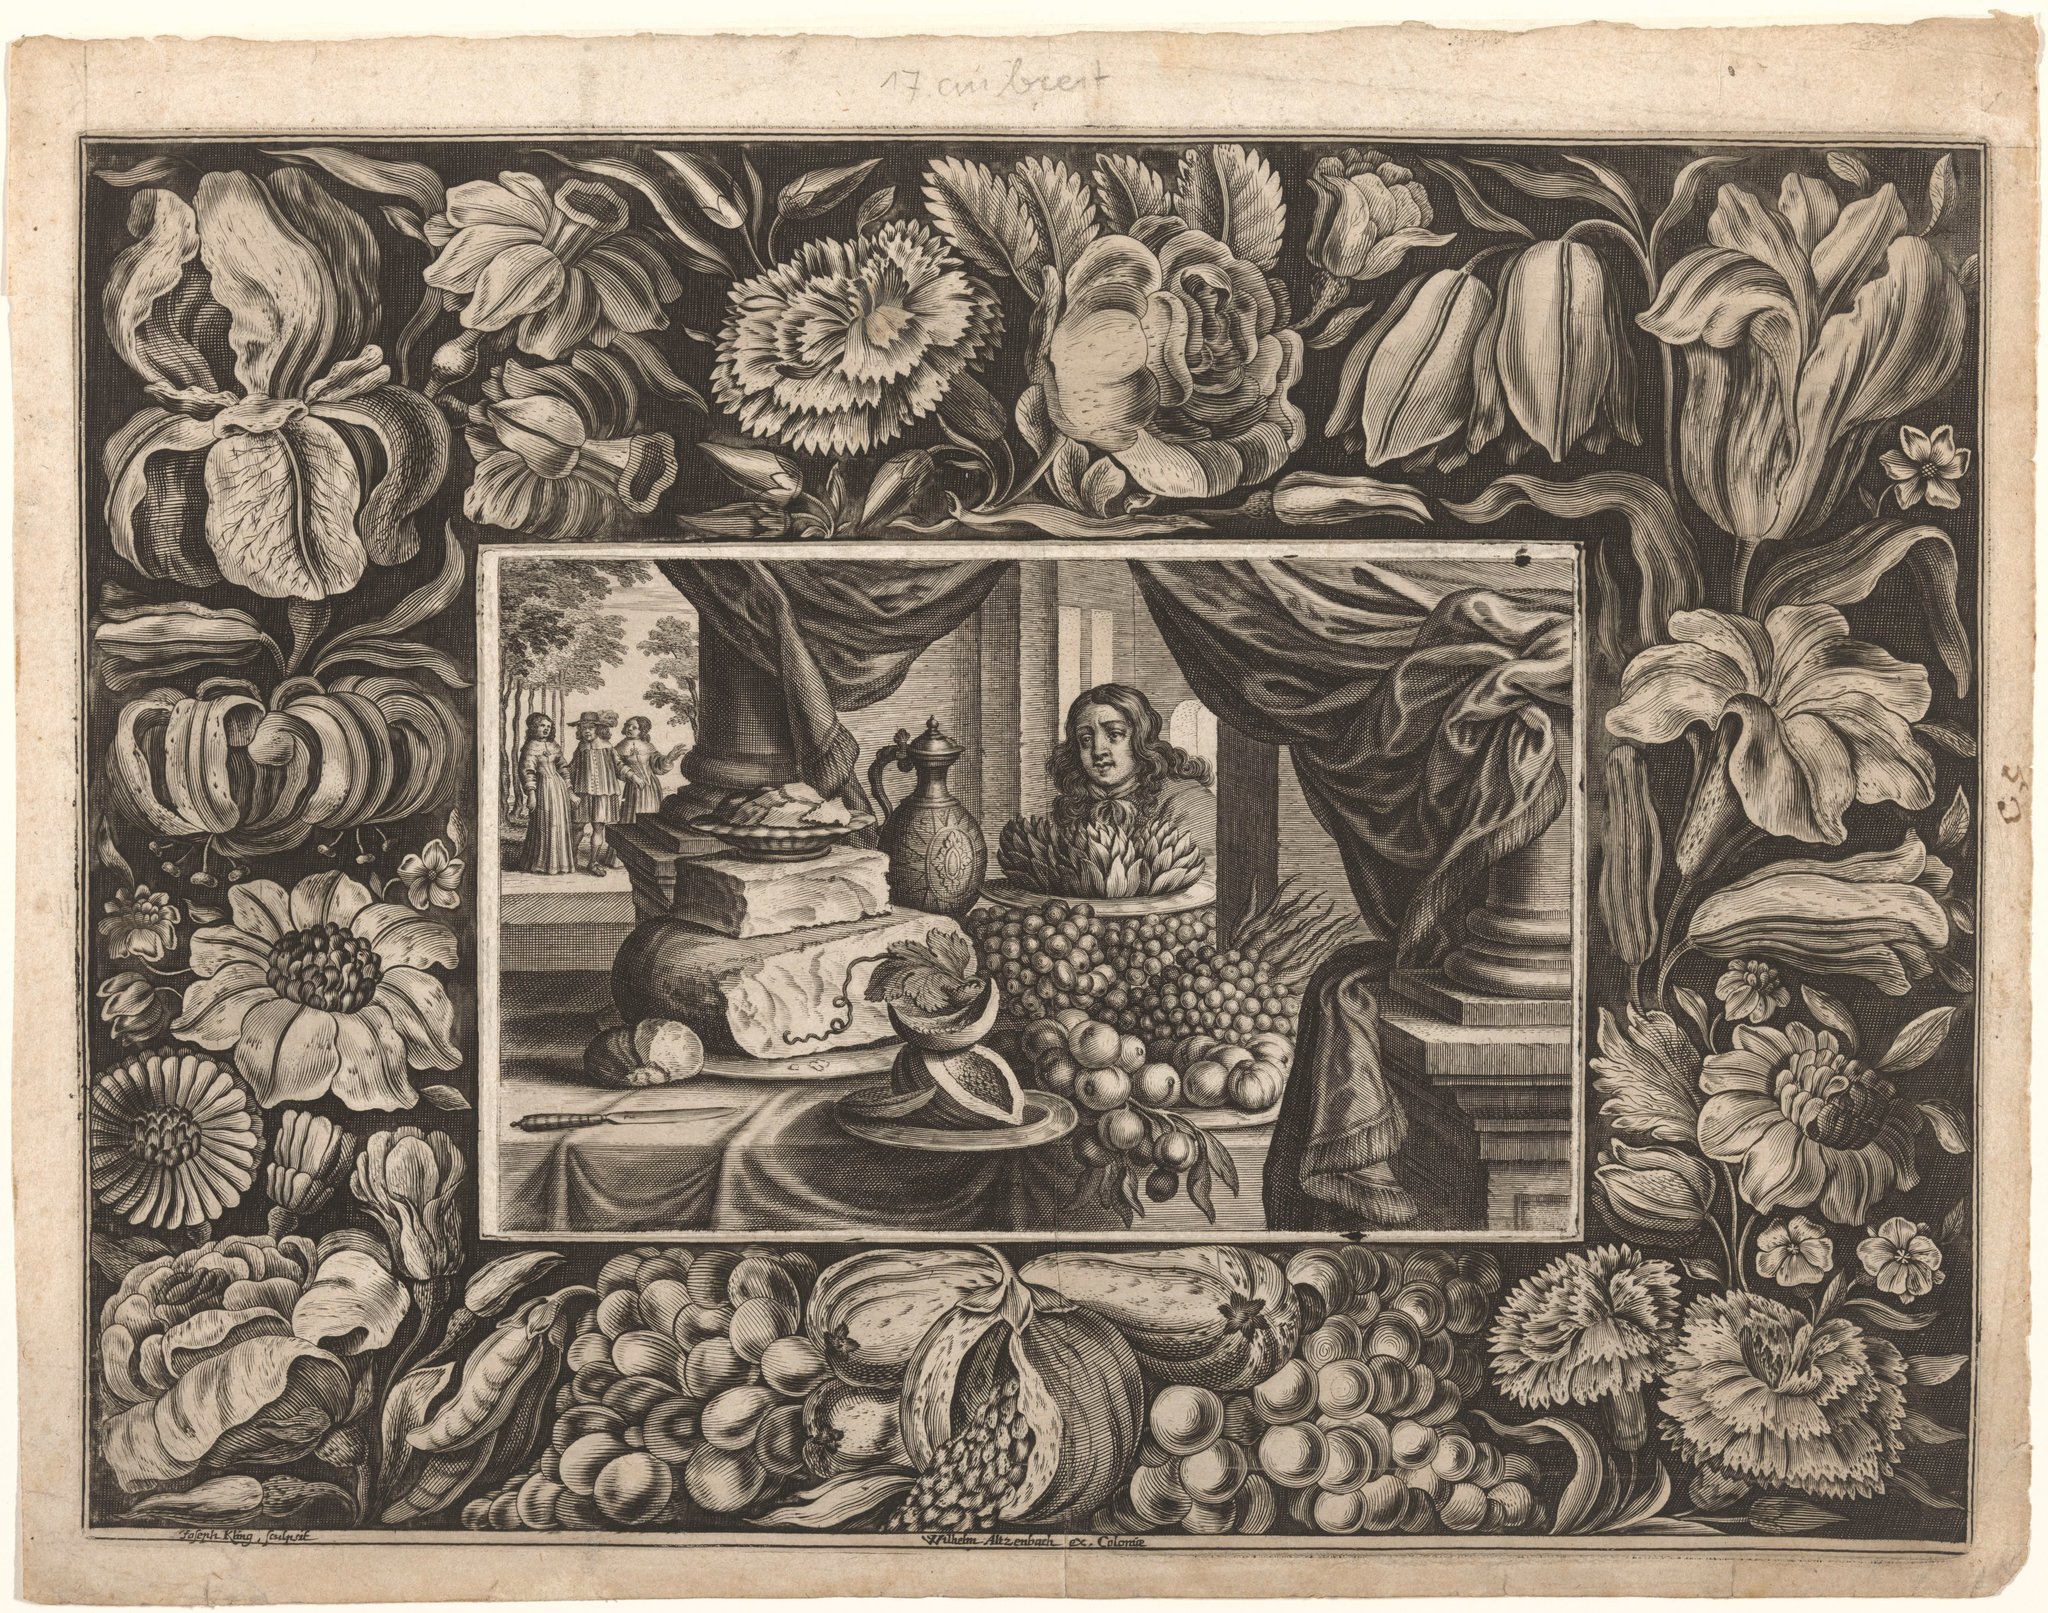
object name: print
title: Stilleven van kaas en fruit met een ornamentrand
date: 1668-1680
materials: paper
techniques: engraving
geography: germany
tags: plants; vegetation, (non-fruit) products of plants or trees, still life of related objects, ornament derived from plant forms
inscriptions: collector's mark: Lugt 2228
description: Achteraan een gezelschap van drie figuren, vooraan draperieën om zuilen en een man bij het stilleven. De voorstelling is omvat door brede ornamentrand bestaande uit bloemen, groente en fruit.